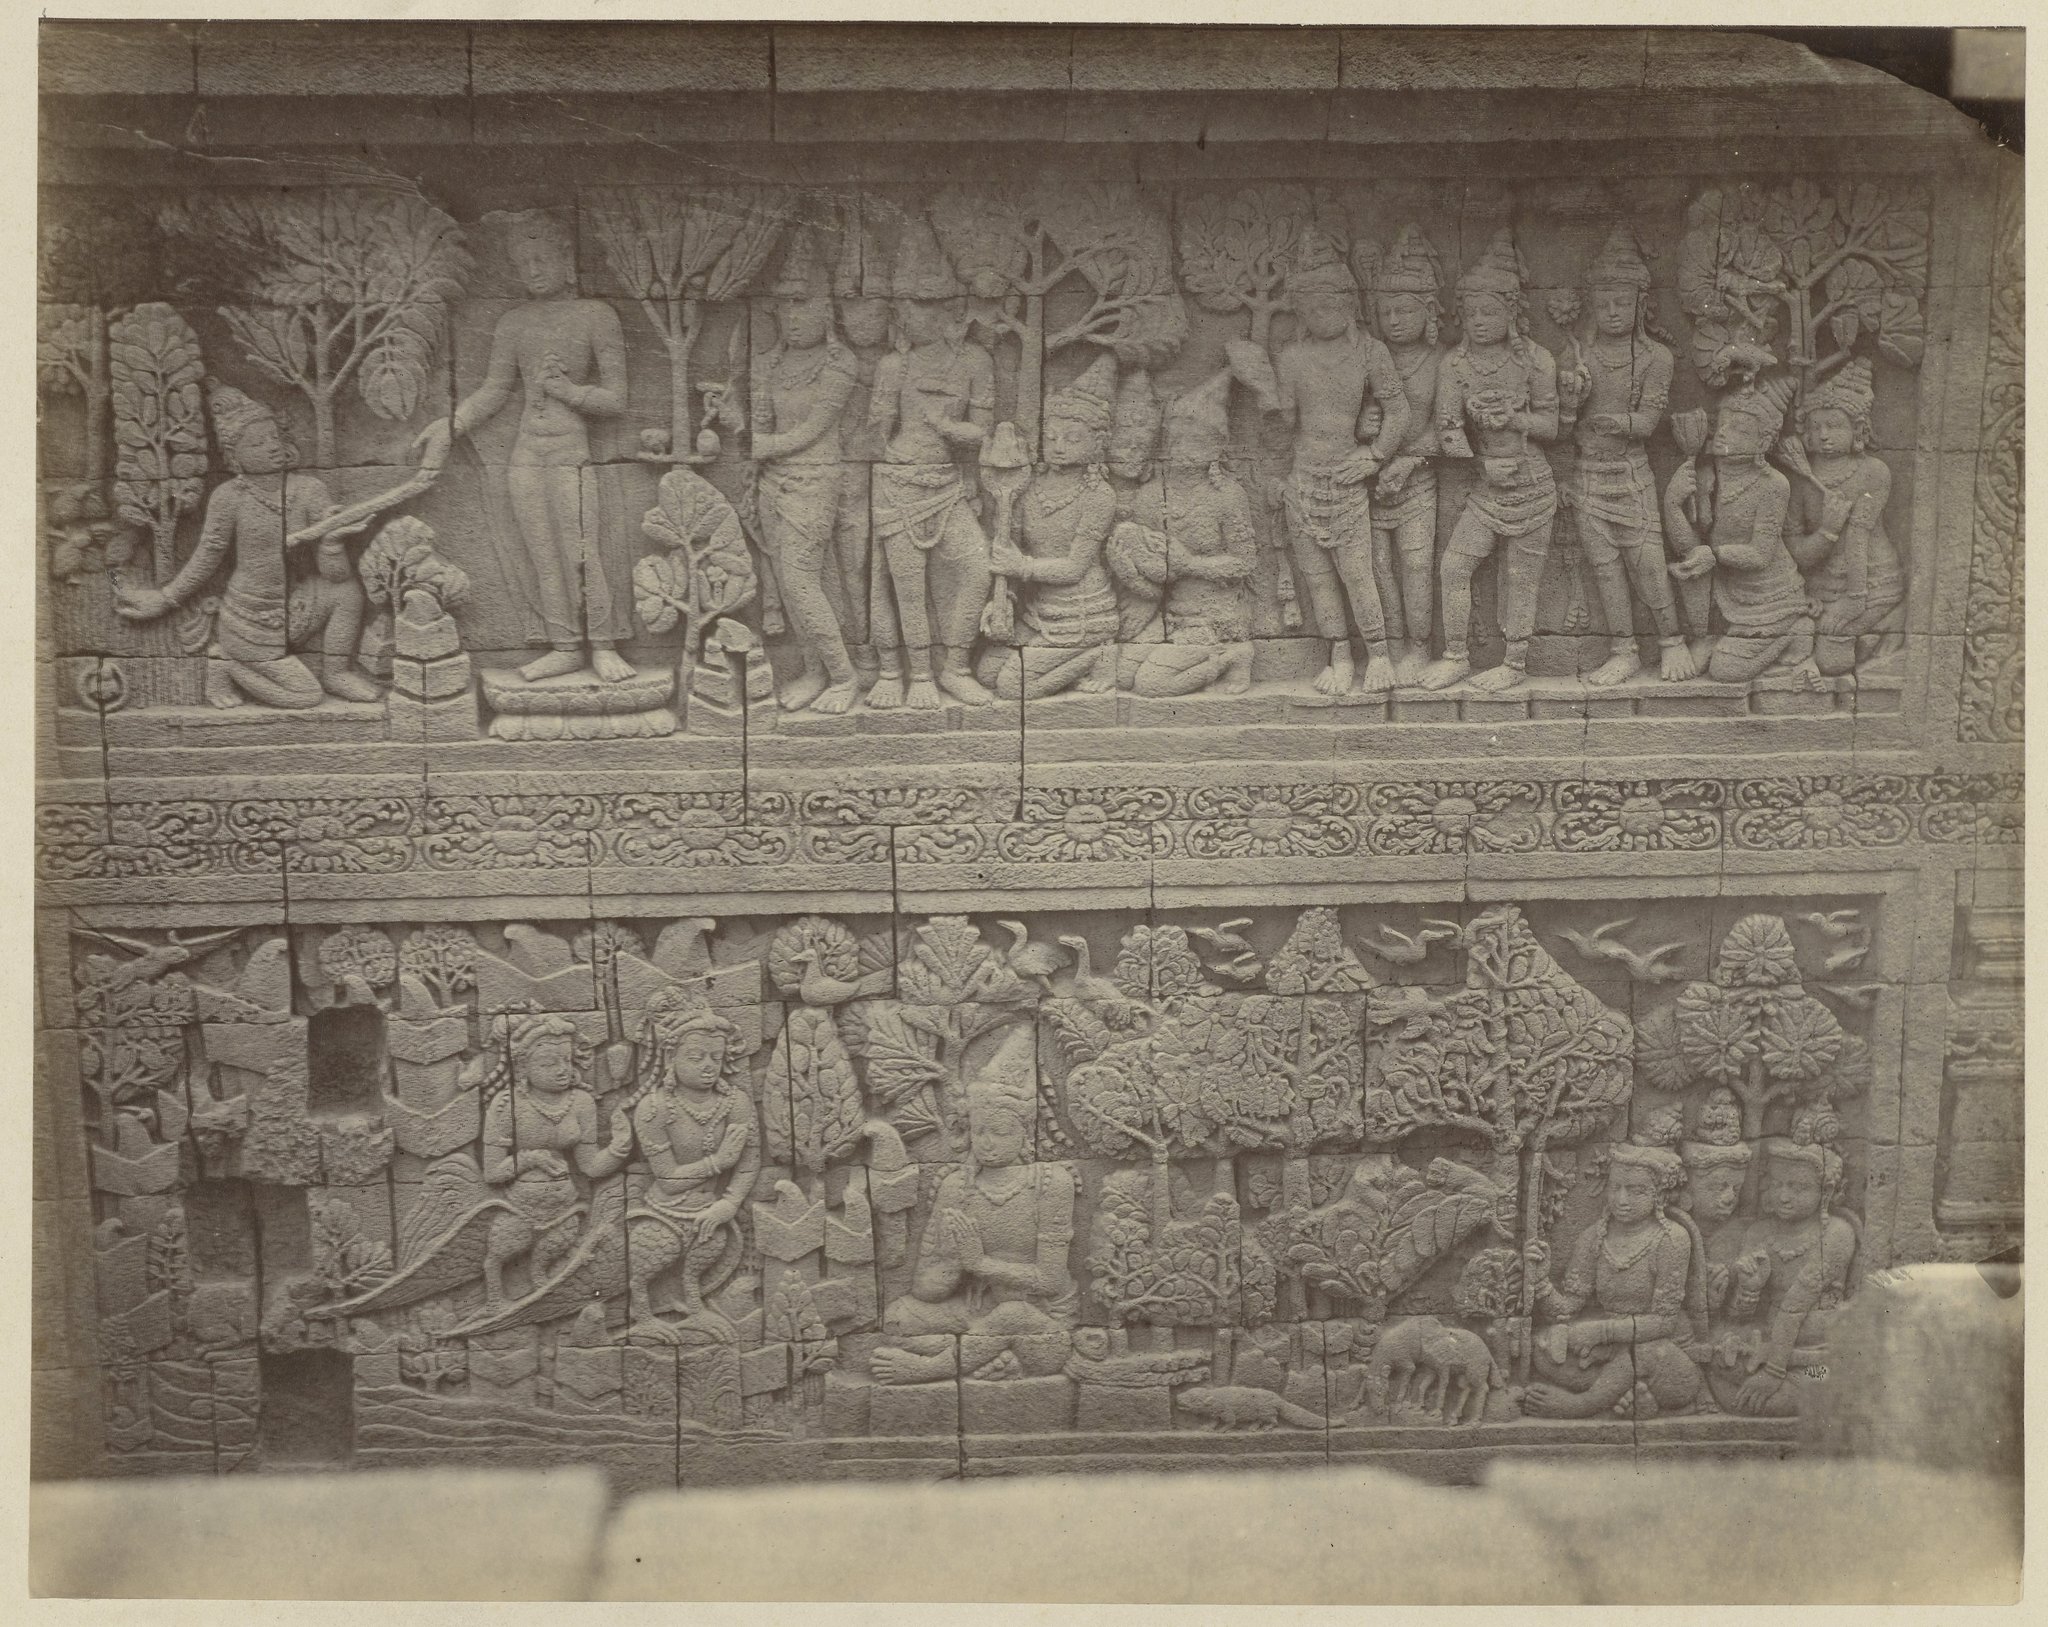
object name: photograph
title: Idem 2e gaanderij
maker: isidore kinsbergen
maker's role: fotograaf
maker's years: 1821-1905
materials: cardboard, paper, photographic support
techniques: albumen print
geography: java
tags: borobudur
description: Gallery I, main wall, north side 41 (top): Relief 1a-78, Lalitavistara relief, The deceased mother of Siddhartha, in the form of the goddess Mahadevi, visits him while he is fasting and meditating. 44 (bottom): relief 1b-79, Avadana relief, Rudrayana story, Rudrayana learns about the misconduct of his son, the new King Cikhandin; King Cikhandin plans his assasination. Borobudur village, Magelang district, Central Java province, 778-824 AD.